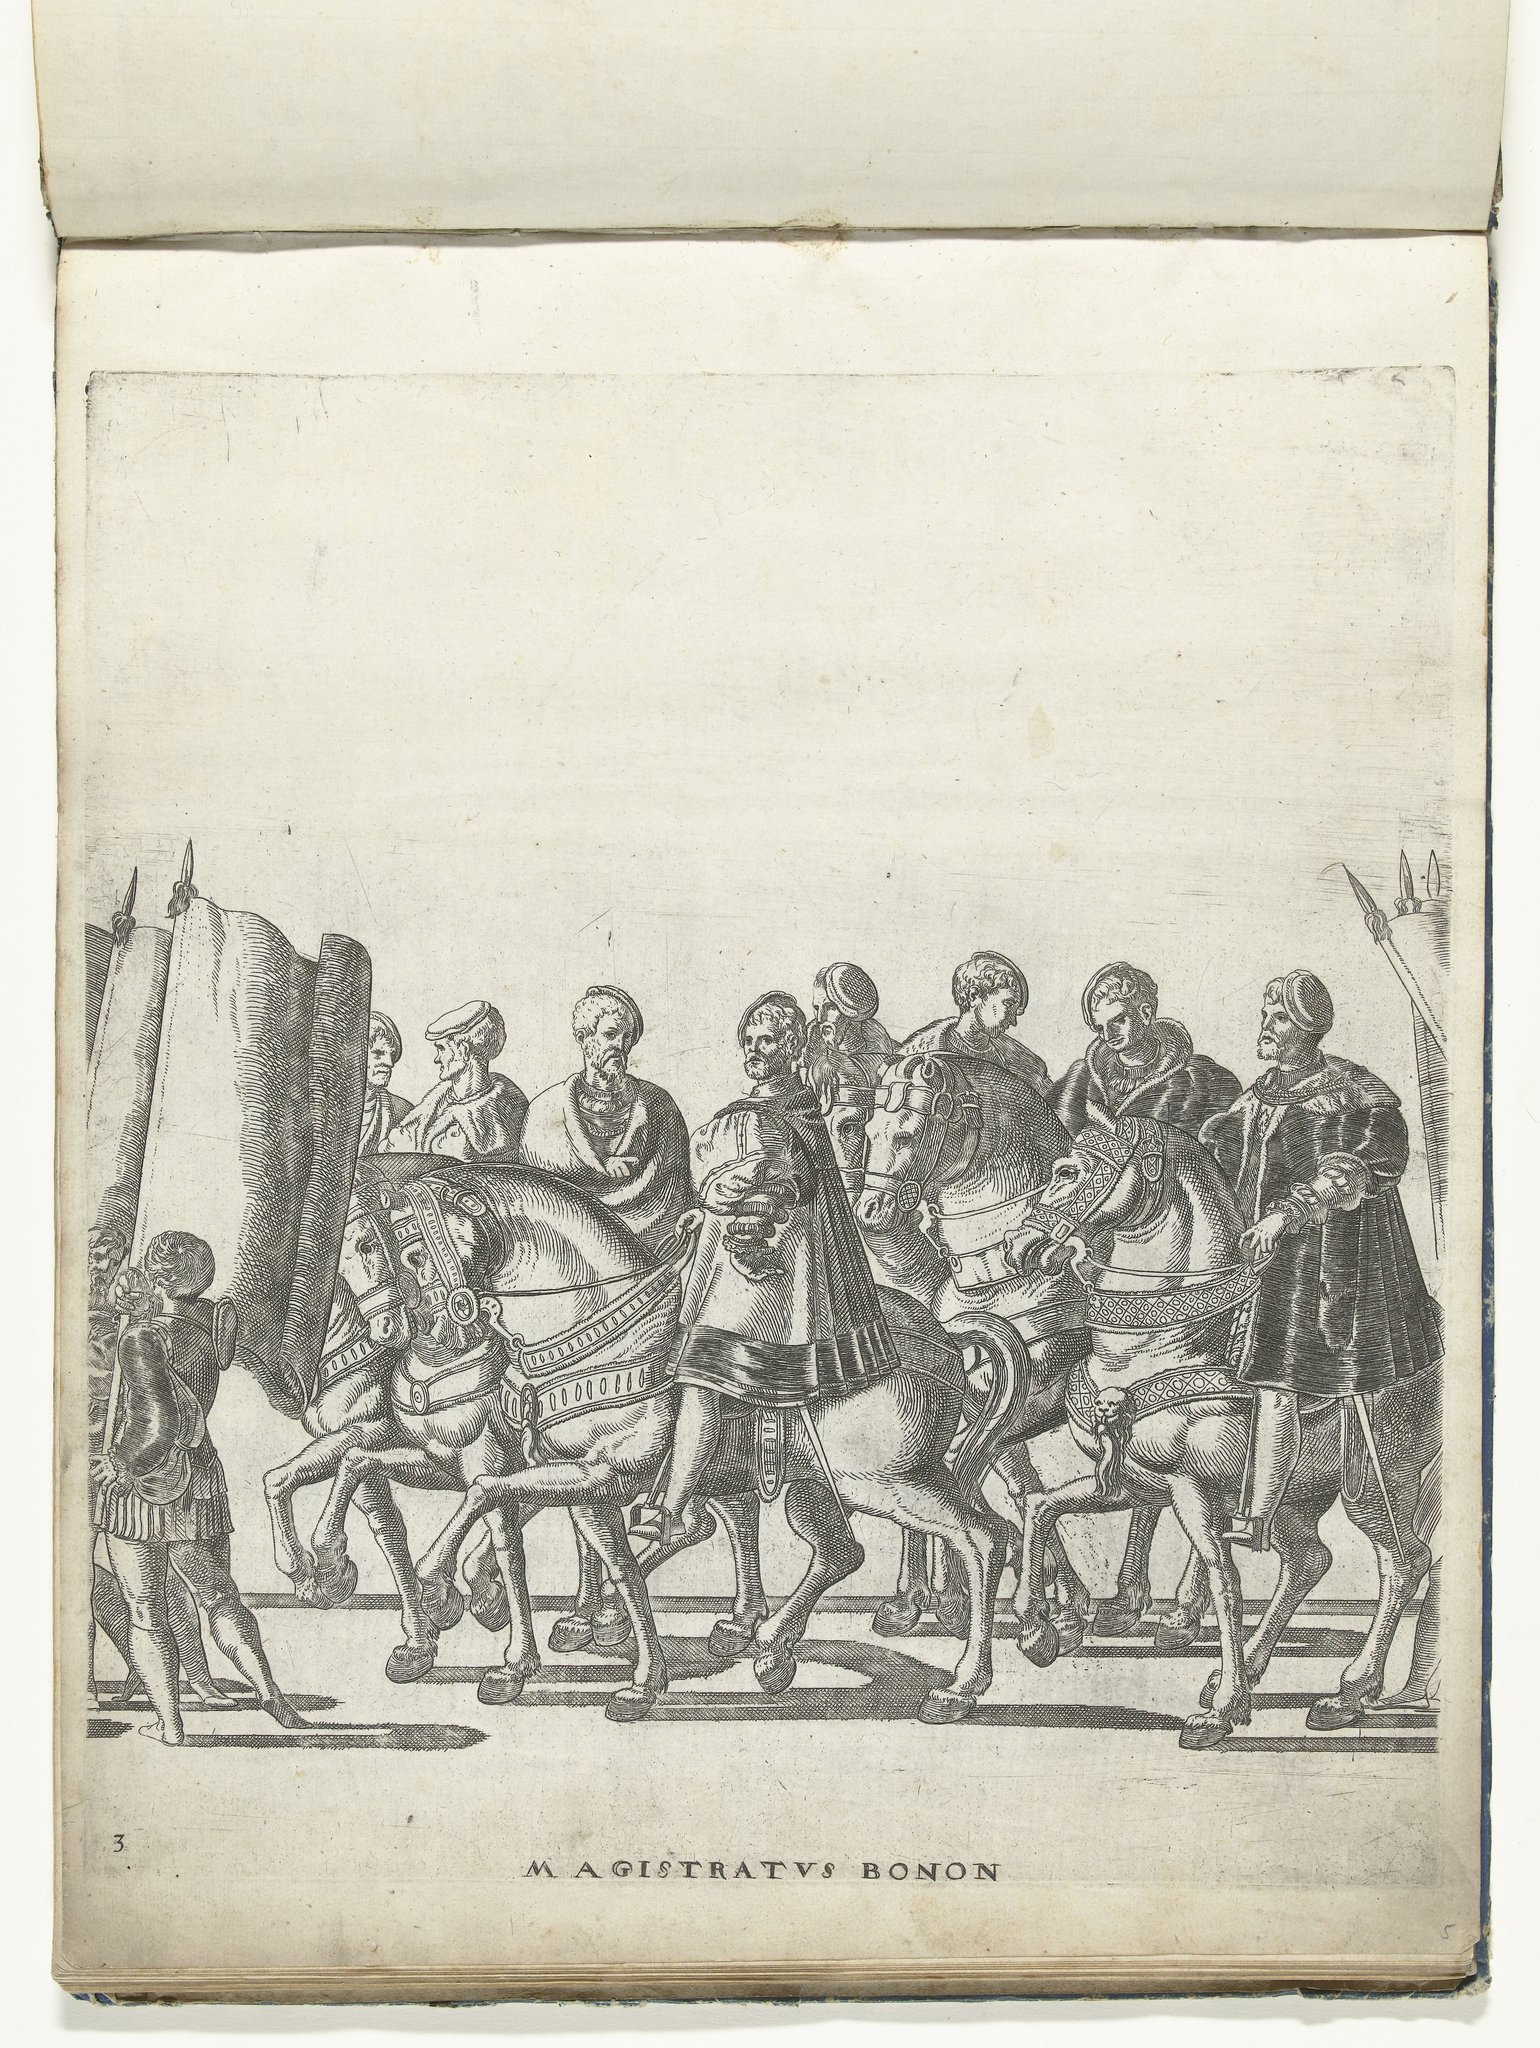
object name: propagandaprent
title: Optocht van Karel V met de paus te Bologna na zijn kroning to keizer, 1530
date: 1530-1536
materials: paper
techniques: engraving, etching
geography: the hague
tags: charles v (holy roman emperor and king of spain), rome, festivities (+ parade, pageant, cavalcade ~ festive activities)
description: Prent in het album waarin zijn ingeplakt de 40 platen die achterelkaar samen het fries vormen van de optocht van Karel V met de paus Clemens VII te Bologna na zijn kroning tot keizer, 24 februari 1530.